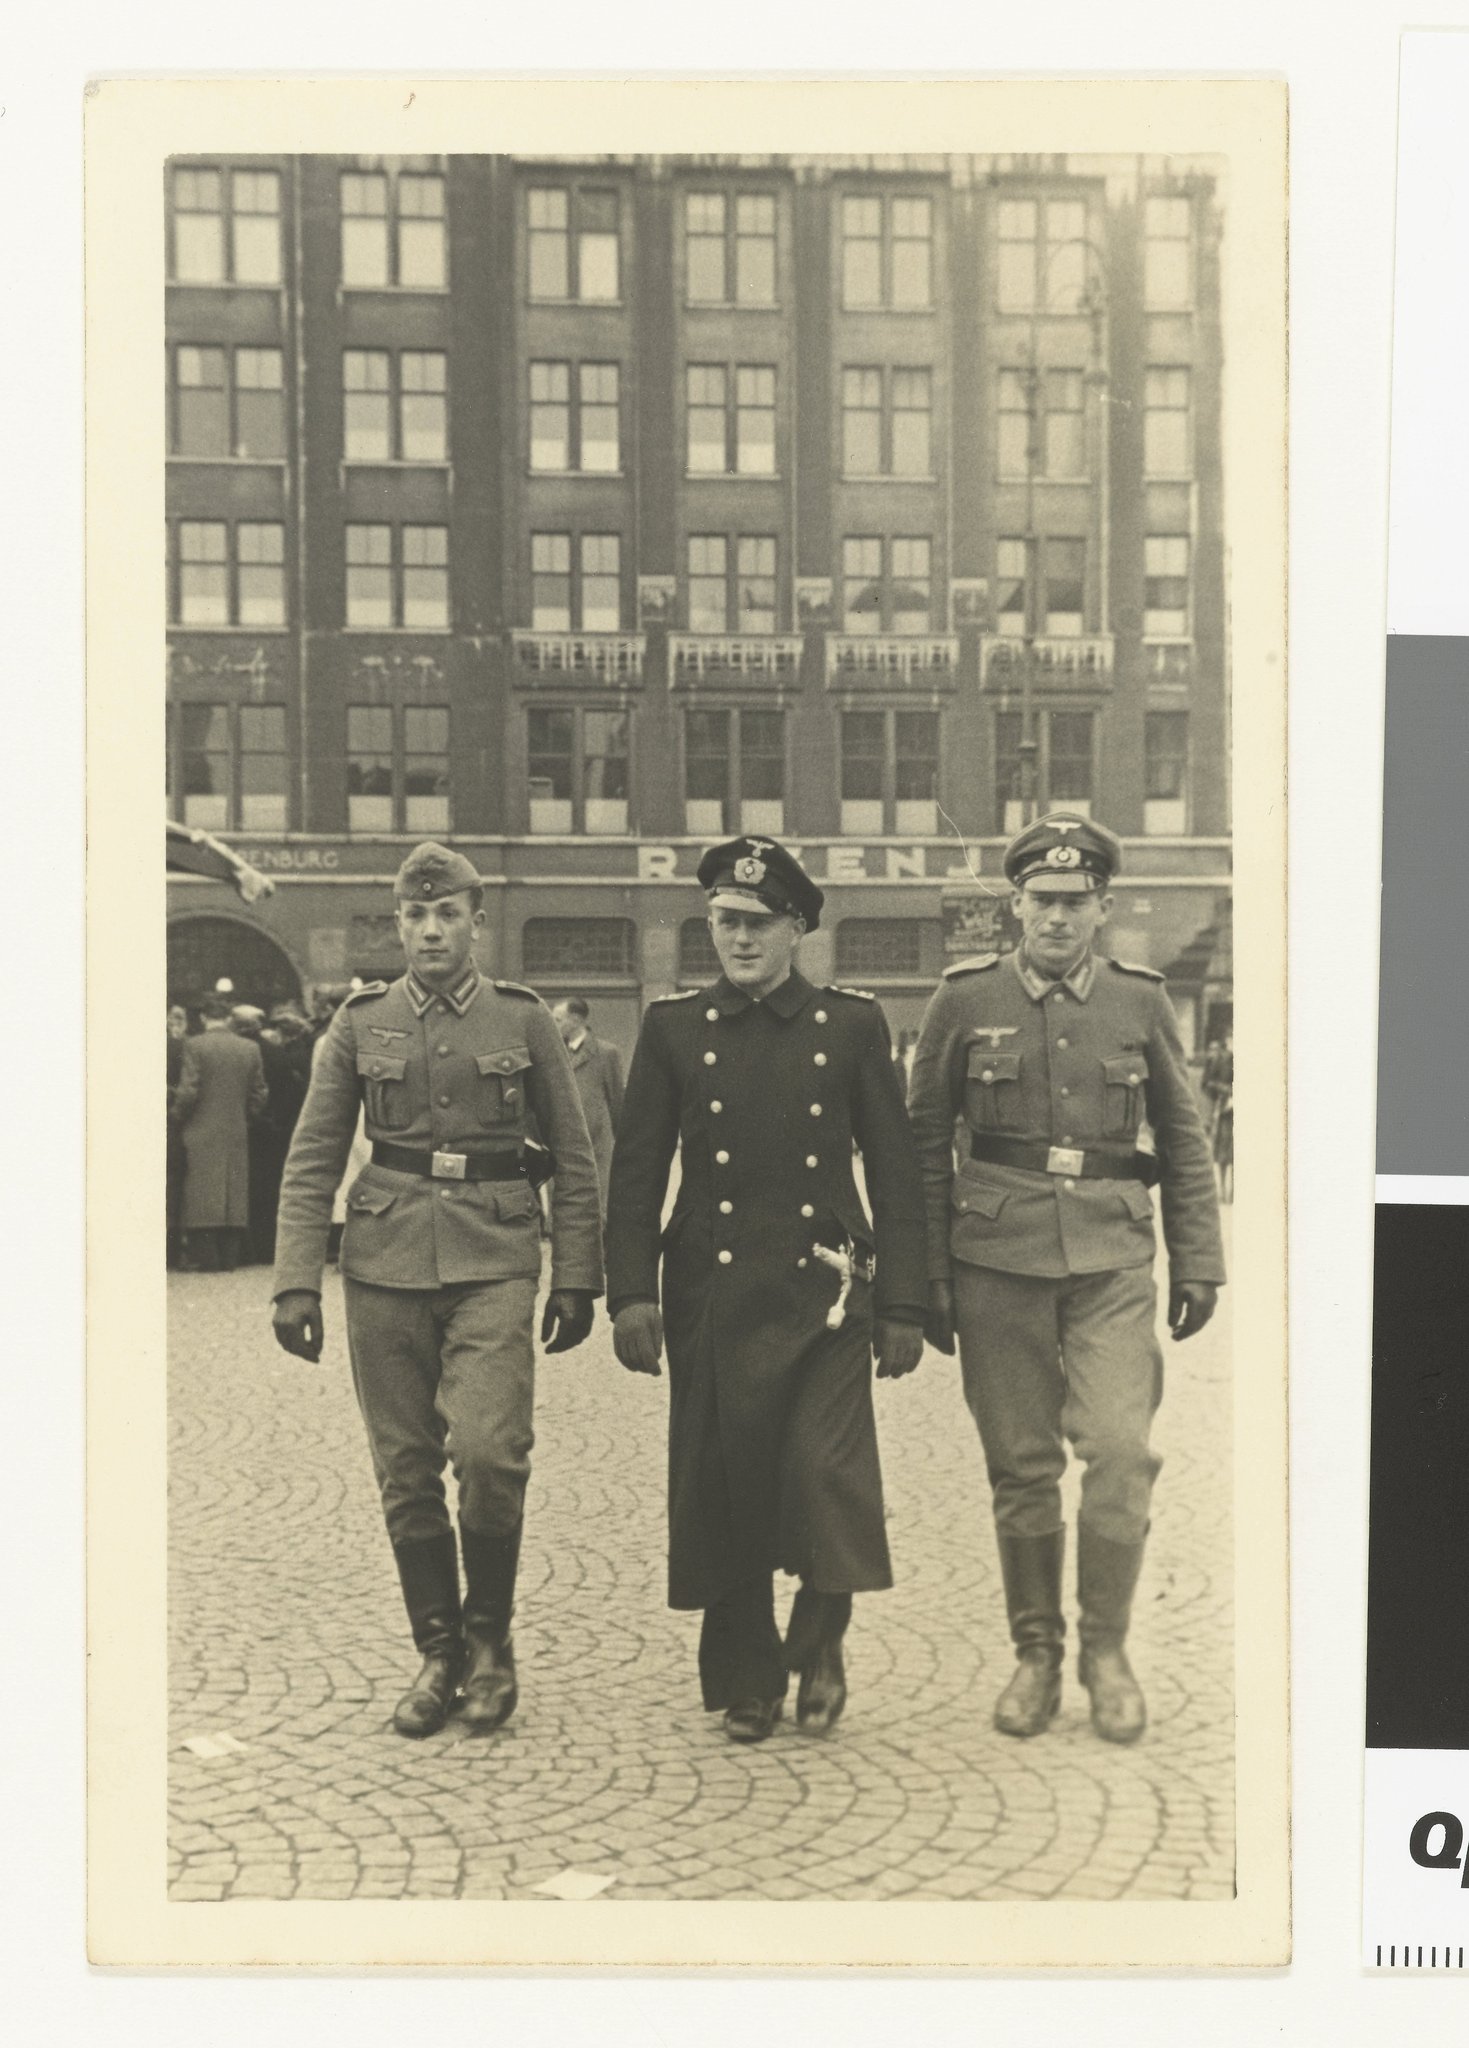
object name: photograph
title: Een Wehrmachtsoldaat, een lid van de Kriegsmarine en een lid van de Luftwaffe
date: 1911-1941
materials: photographic support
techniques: gelatin silver print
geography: amsterdam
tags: occupation ~ war, amsterdam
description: Een Wehrmachtsoldaat, een lid van de Kriegsmarine en een lid van de Luftwaffe lopen in Amsterdam over de Dam voor Peek en Cloppenburg. Achterop staan van twee van de drie naam en rang. Het zou gaan om leden van een kustwachtbatterij.